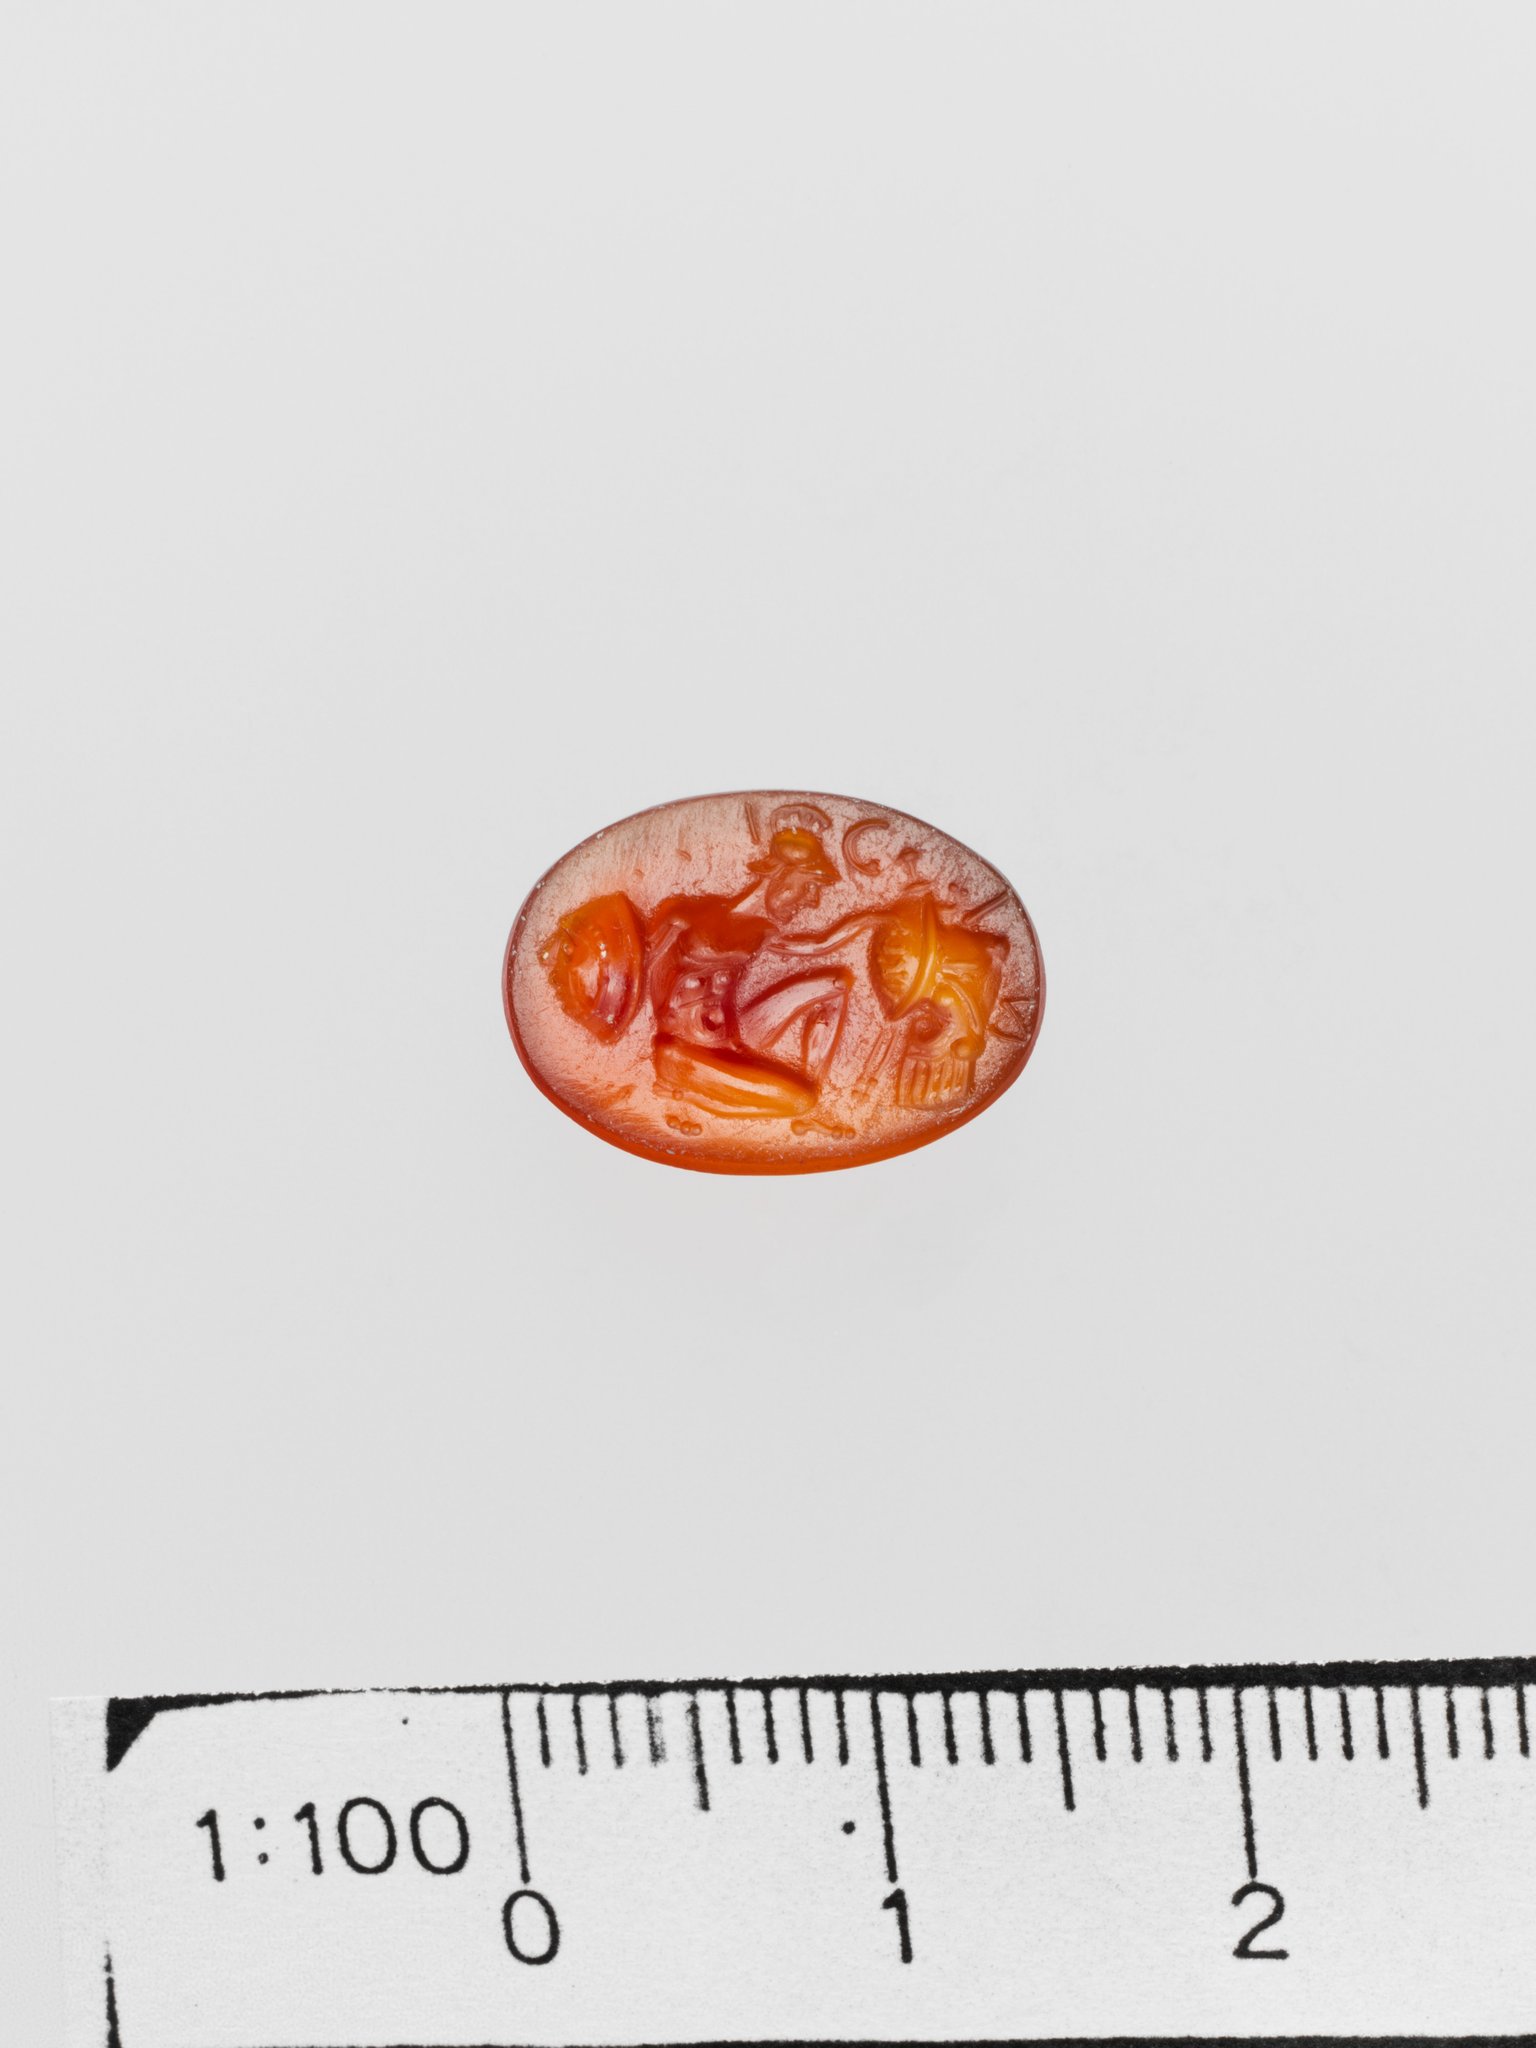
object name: intaglio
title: Carnelian ring stone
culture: italic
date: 300-101 BCE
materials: gemstone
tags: shields,men,writing